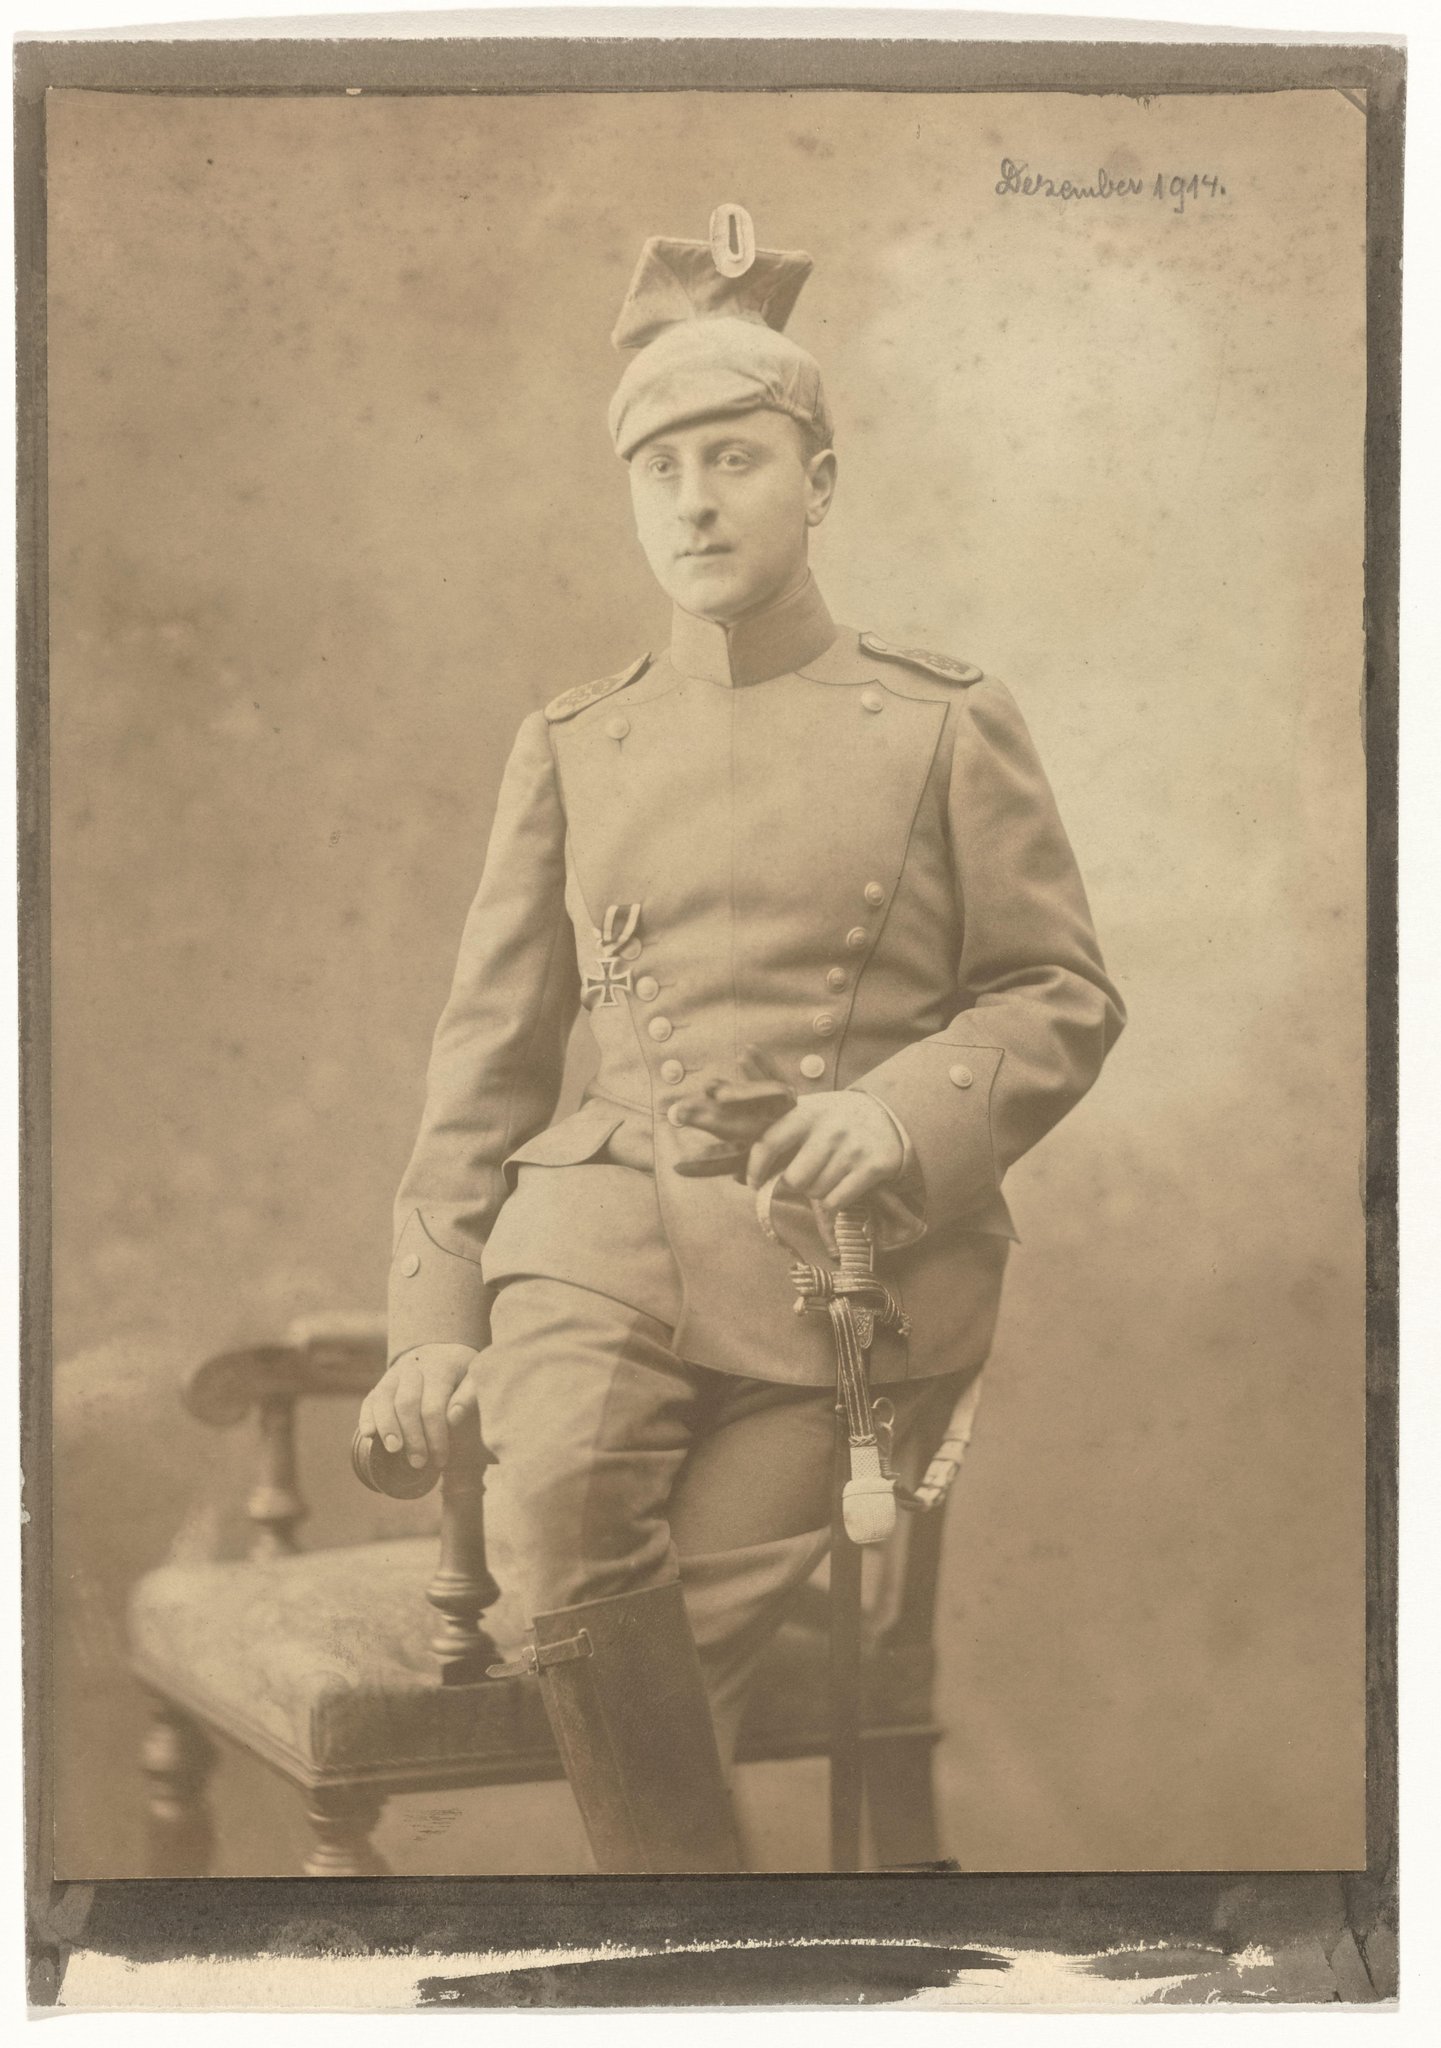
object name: photograph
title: Arthur Moos met chapka en sabel in het uniform van het Duitse leger, met het IJzeren Kruis op de borst, gezeten op een stoelleuning, december 1914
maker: Anonymous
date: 1912-1914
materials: photographic support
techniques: gelatin silver print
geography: straatsburg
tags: arthur moos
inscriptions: date: ‘Dezember 1914. Familie Andenken Strassburg’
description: Arthur Moos met chapka en sabel in het uniform van het Duitse leger, met het IJzeren Kruis op de borst, gezeten op een stoelleuning.